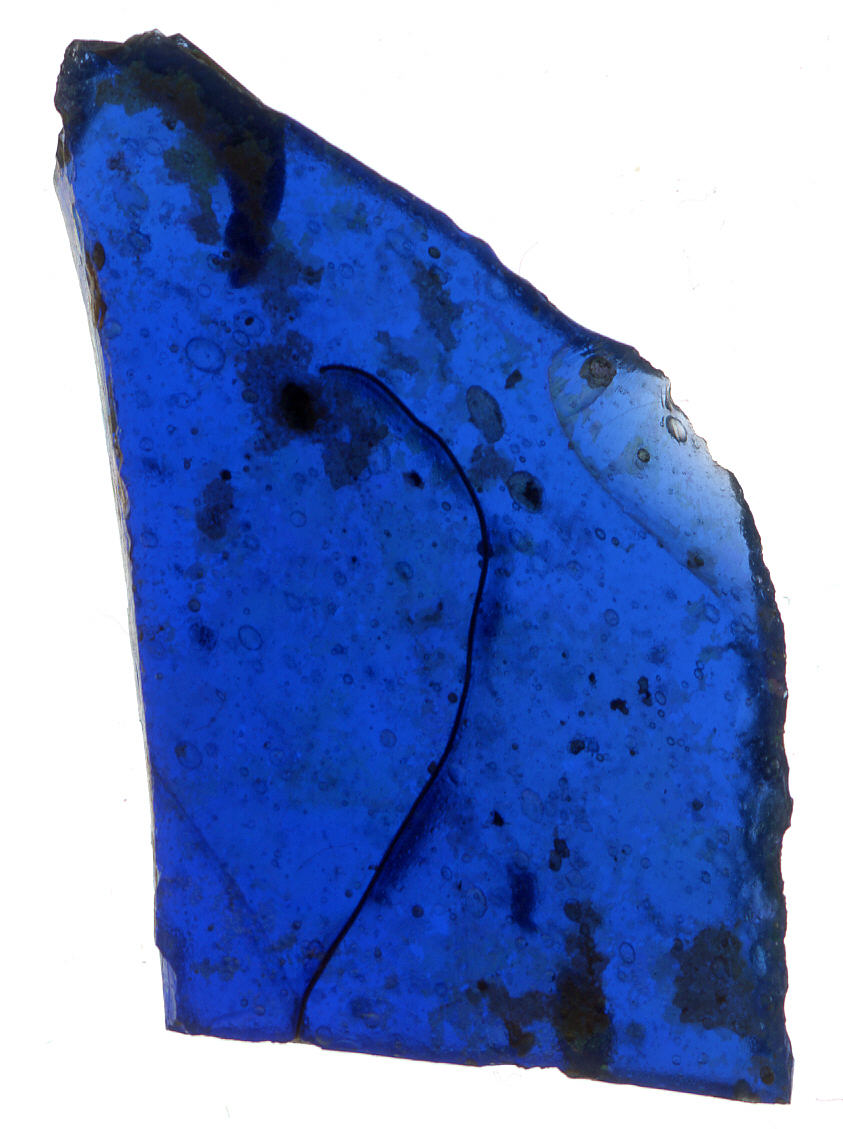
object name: fragment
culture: crusader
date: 1201-1300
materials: glass